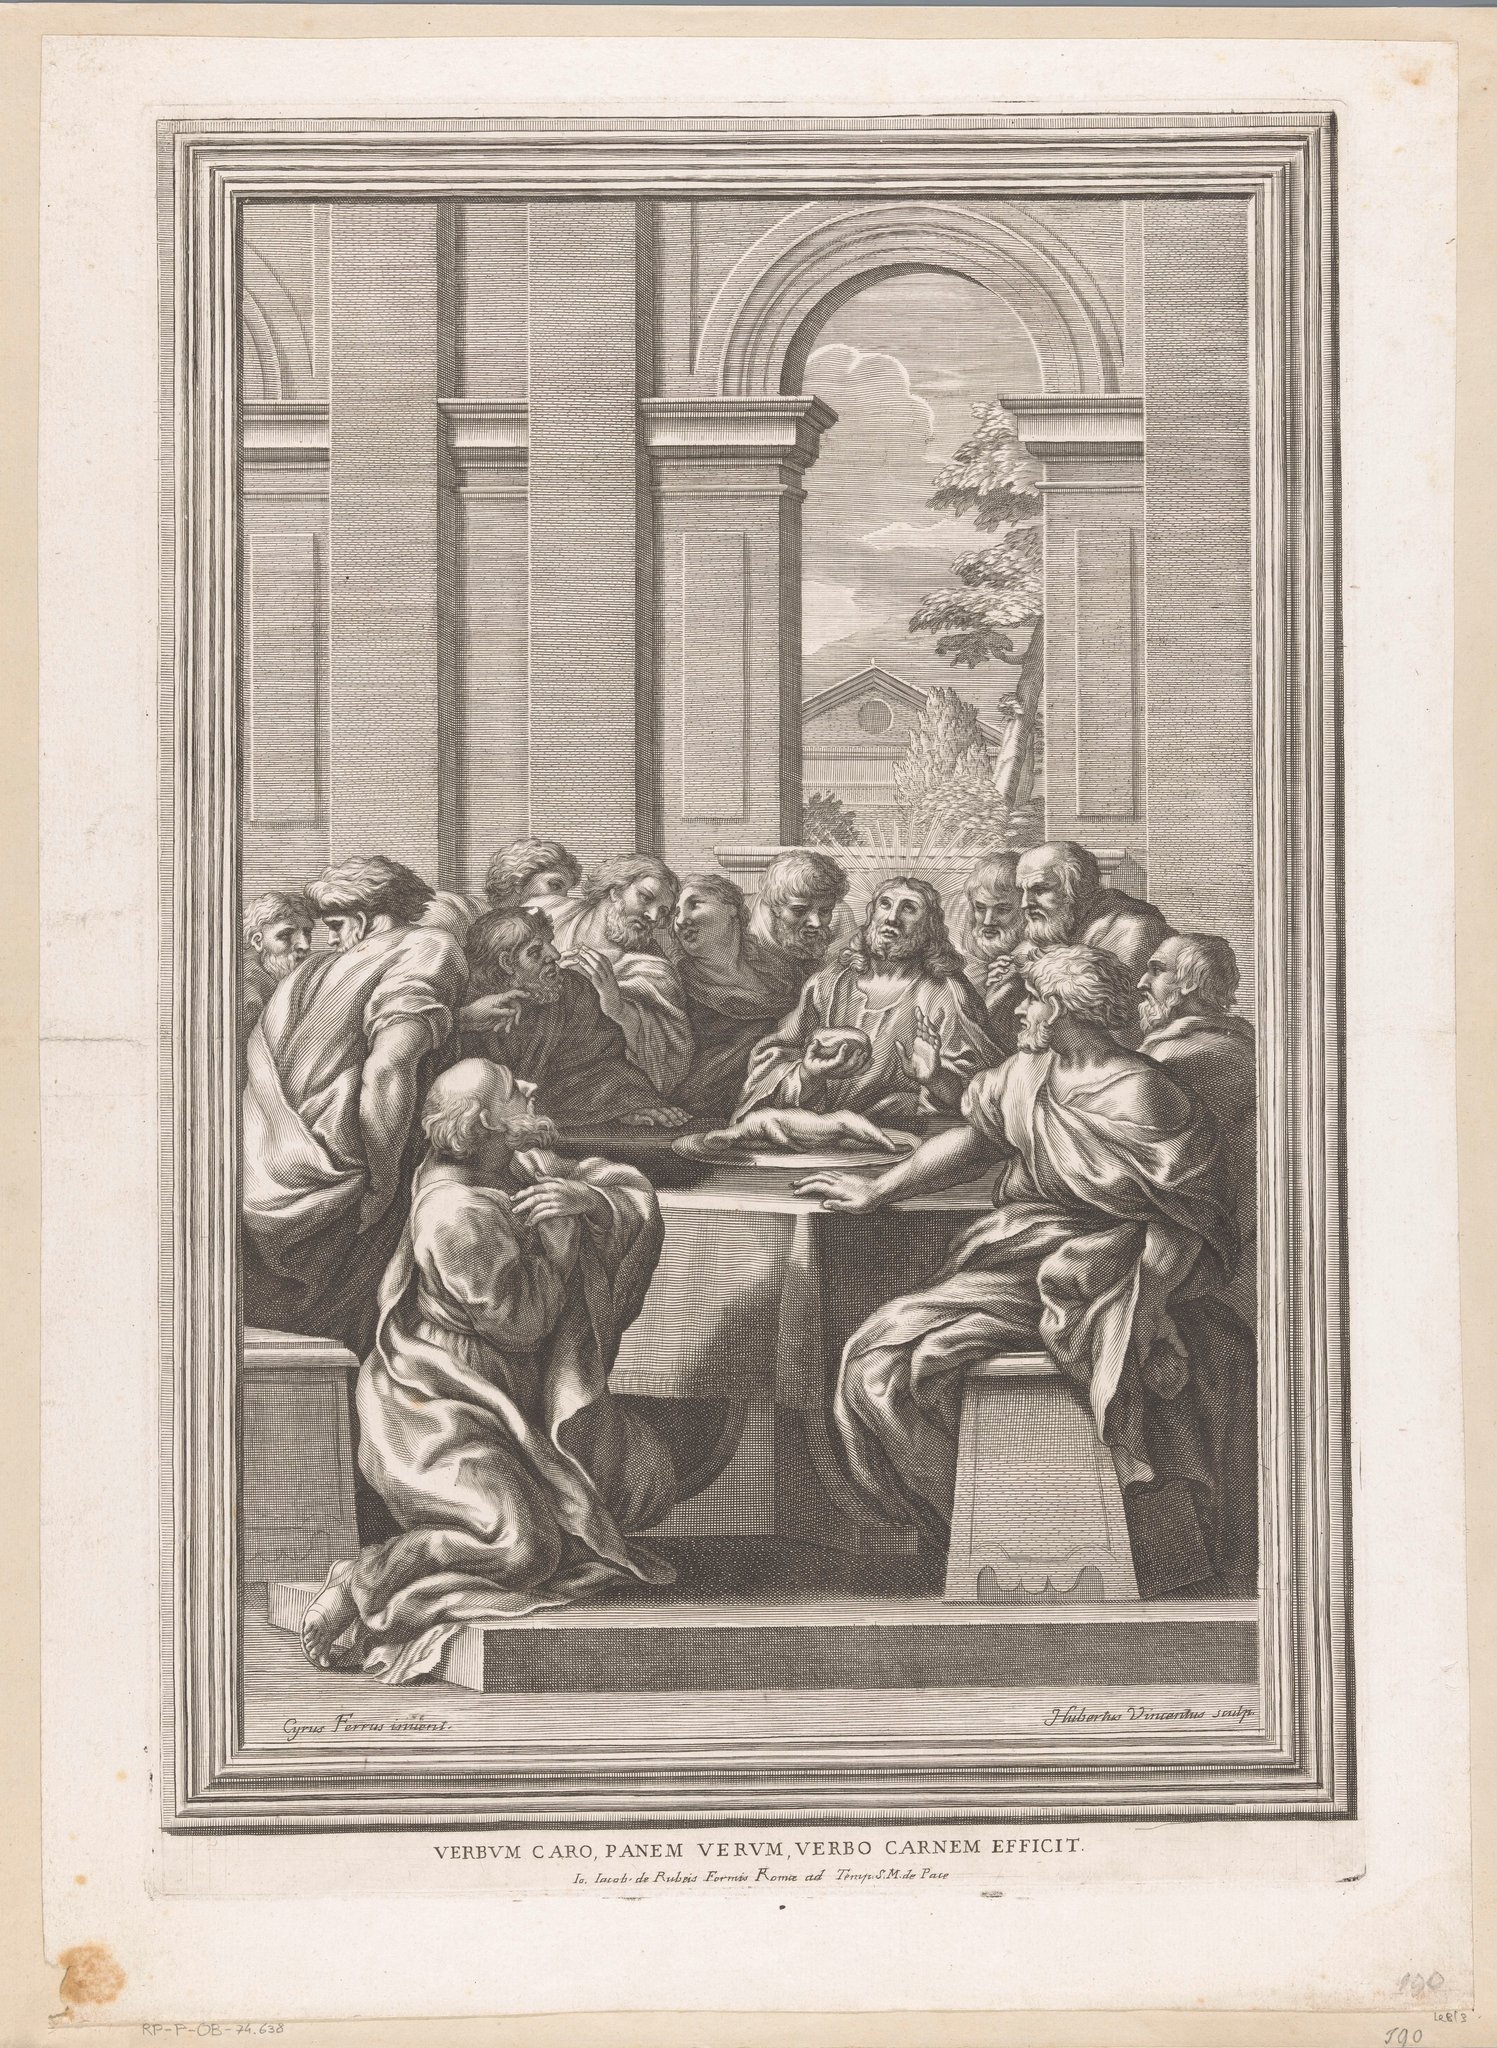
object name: print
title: Laatste Avondmaal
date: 1680-1691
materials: paper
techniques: engraving, etching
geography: rome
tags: last supper (in general) (matthew 26:21-35; mark 14:18-31; luke 22:3, 22:15-23; john 13:21-38)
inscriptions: collector's mark: Lugt 240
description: Prent naar een tekening door Ciro Ferri in het Metropolitan Museum of Art, New York, inv.nr. 68.38.